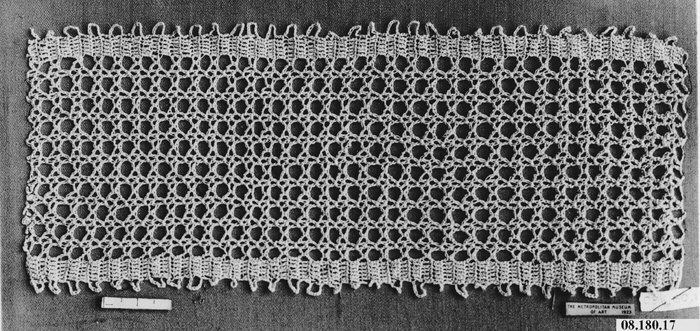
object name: band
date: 1801-1900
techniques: crochet